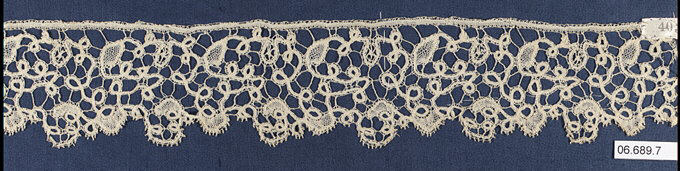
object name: piece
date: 1801-1900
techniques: lace